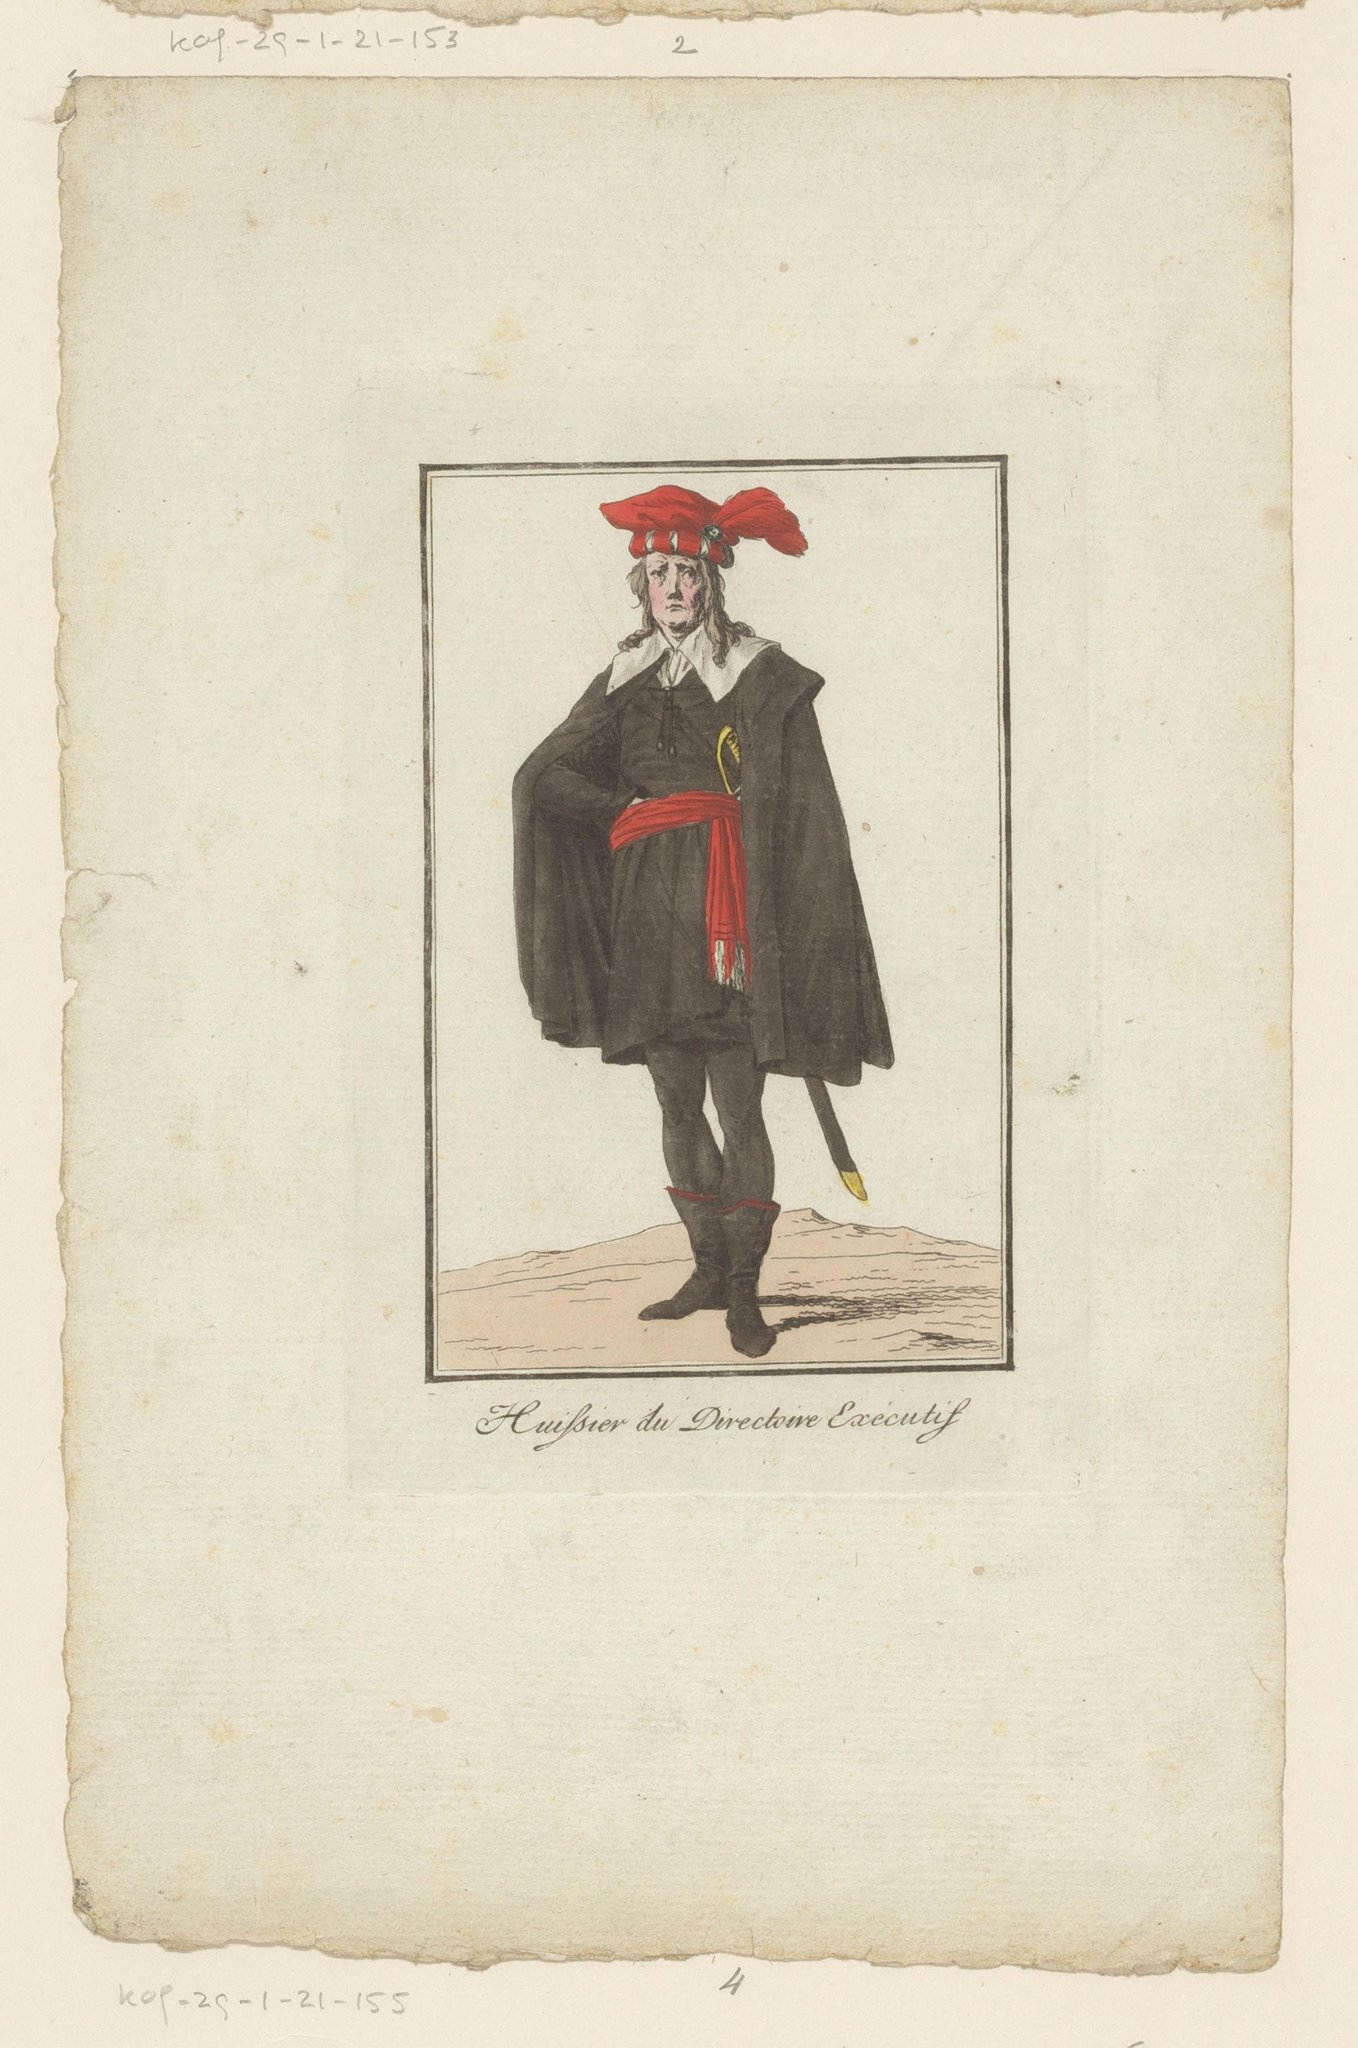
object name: print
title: Huissier du Directoire Executif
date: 1795-1799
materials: paper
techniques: etching, hand coloring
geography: paris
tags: national government, clothes, costume, head-gear: hat (+ feathers used for clothes)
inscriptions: stamp, collector's mark: Lugt 1641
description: Onderwerpsrubrieken binnen de Atlas Zeden en Gewoonten: Zeden en Gewoonten in Engeren Zin, De Kleeding, Kleederdrachten (tijdvakken), De Fransche Revolutie. (Het Directoire).